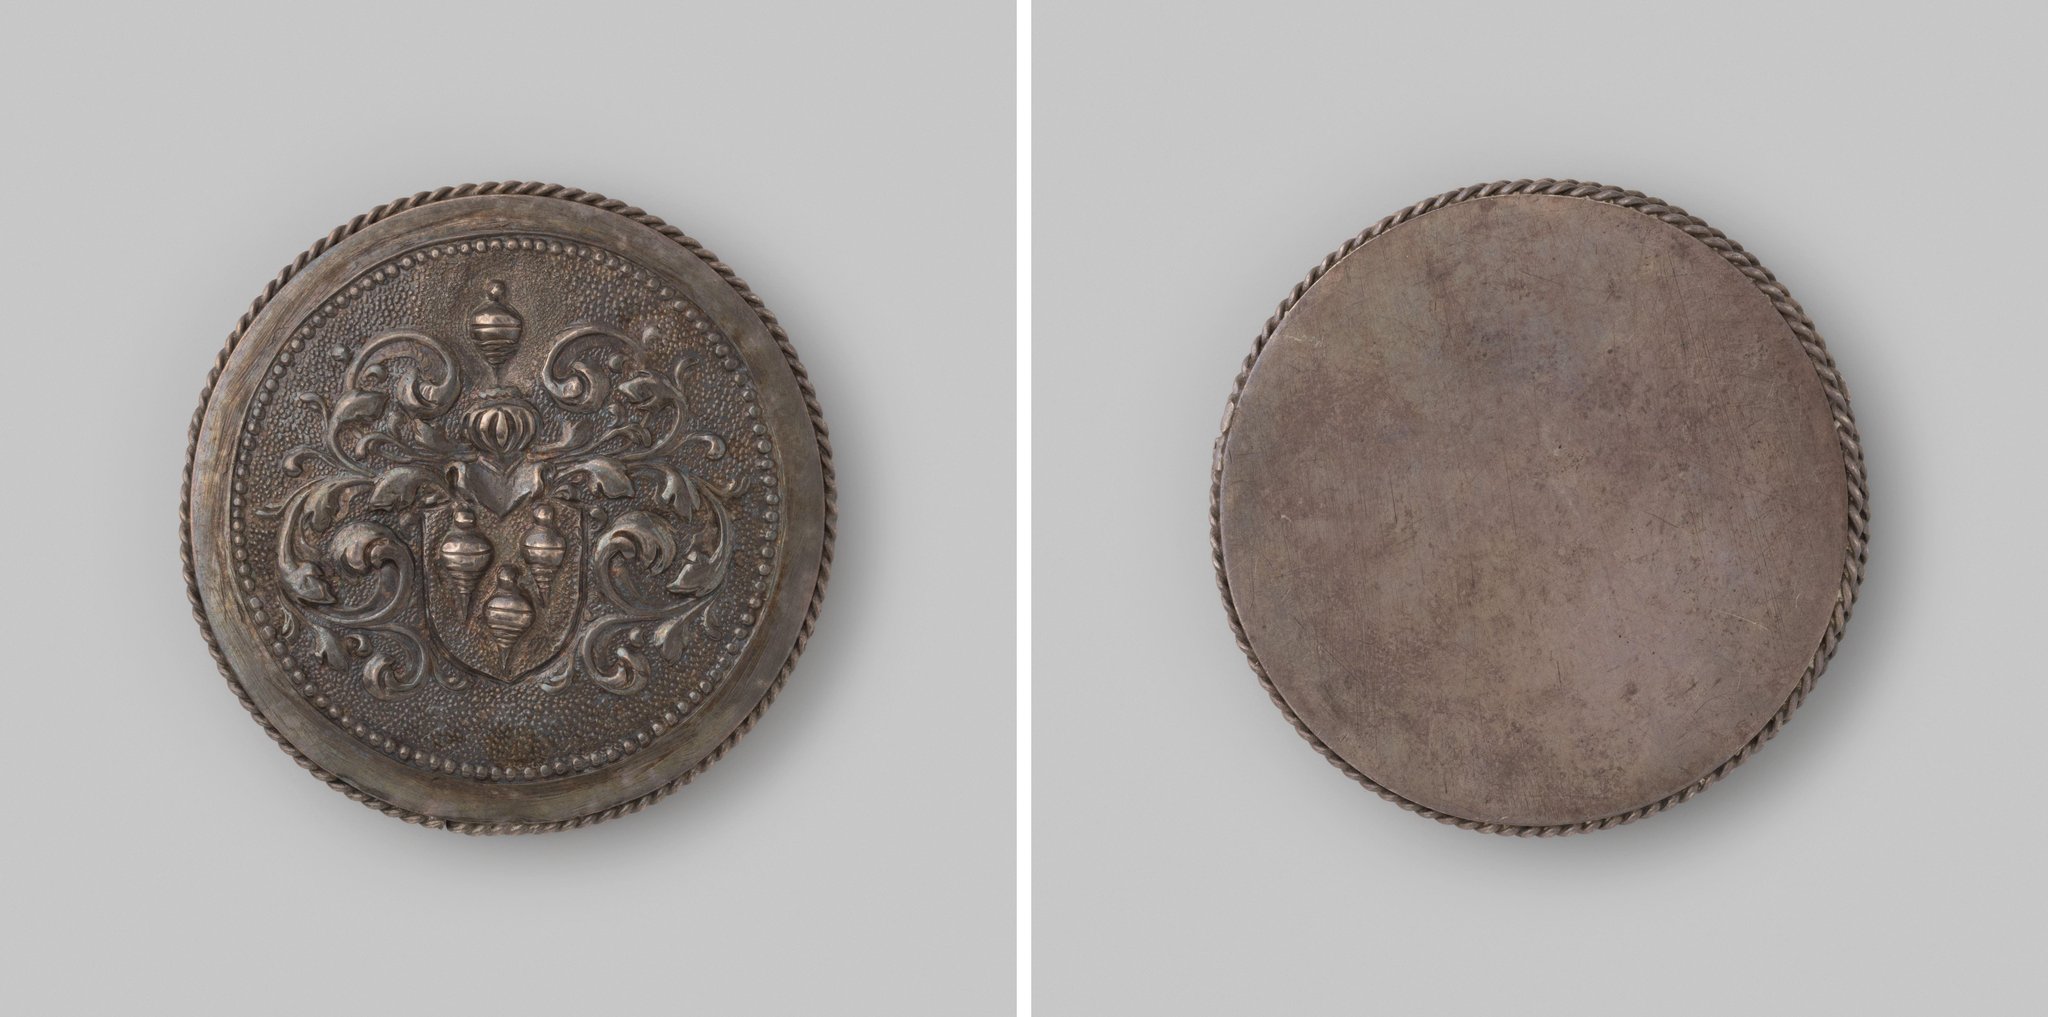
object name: box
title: Doos van gedenkpenning aansprekersoproer te Amsterdam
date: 1696-1930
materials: silver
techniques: repoussé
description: Gedreven zilveren doos in twee delen met bewerkte randen. Het losse deksel is versierd met een familiewapen. Gemaakt voor de gedenkpenning van het aansprekersoproer te Amsterdam in 1696 (KOG-S-MP-20-6)